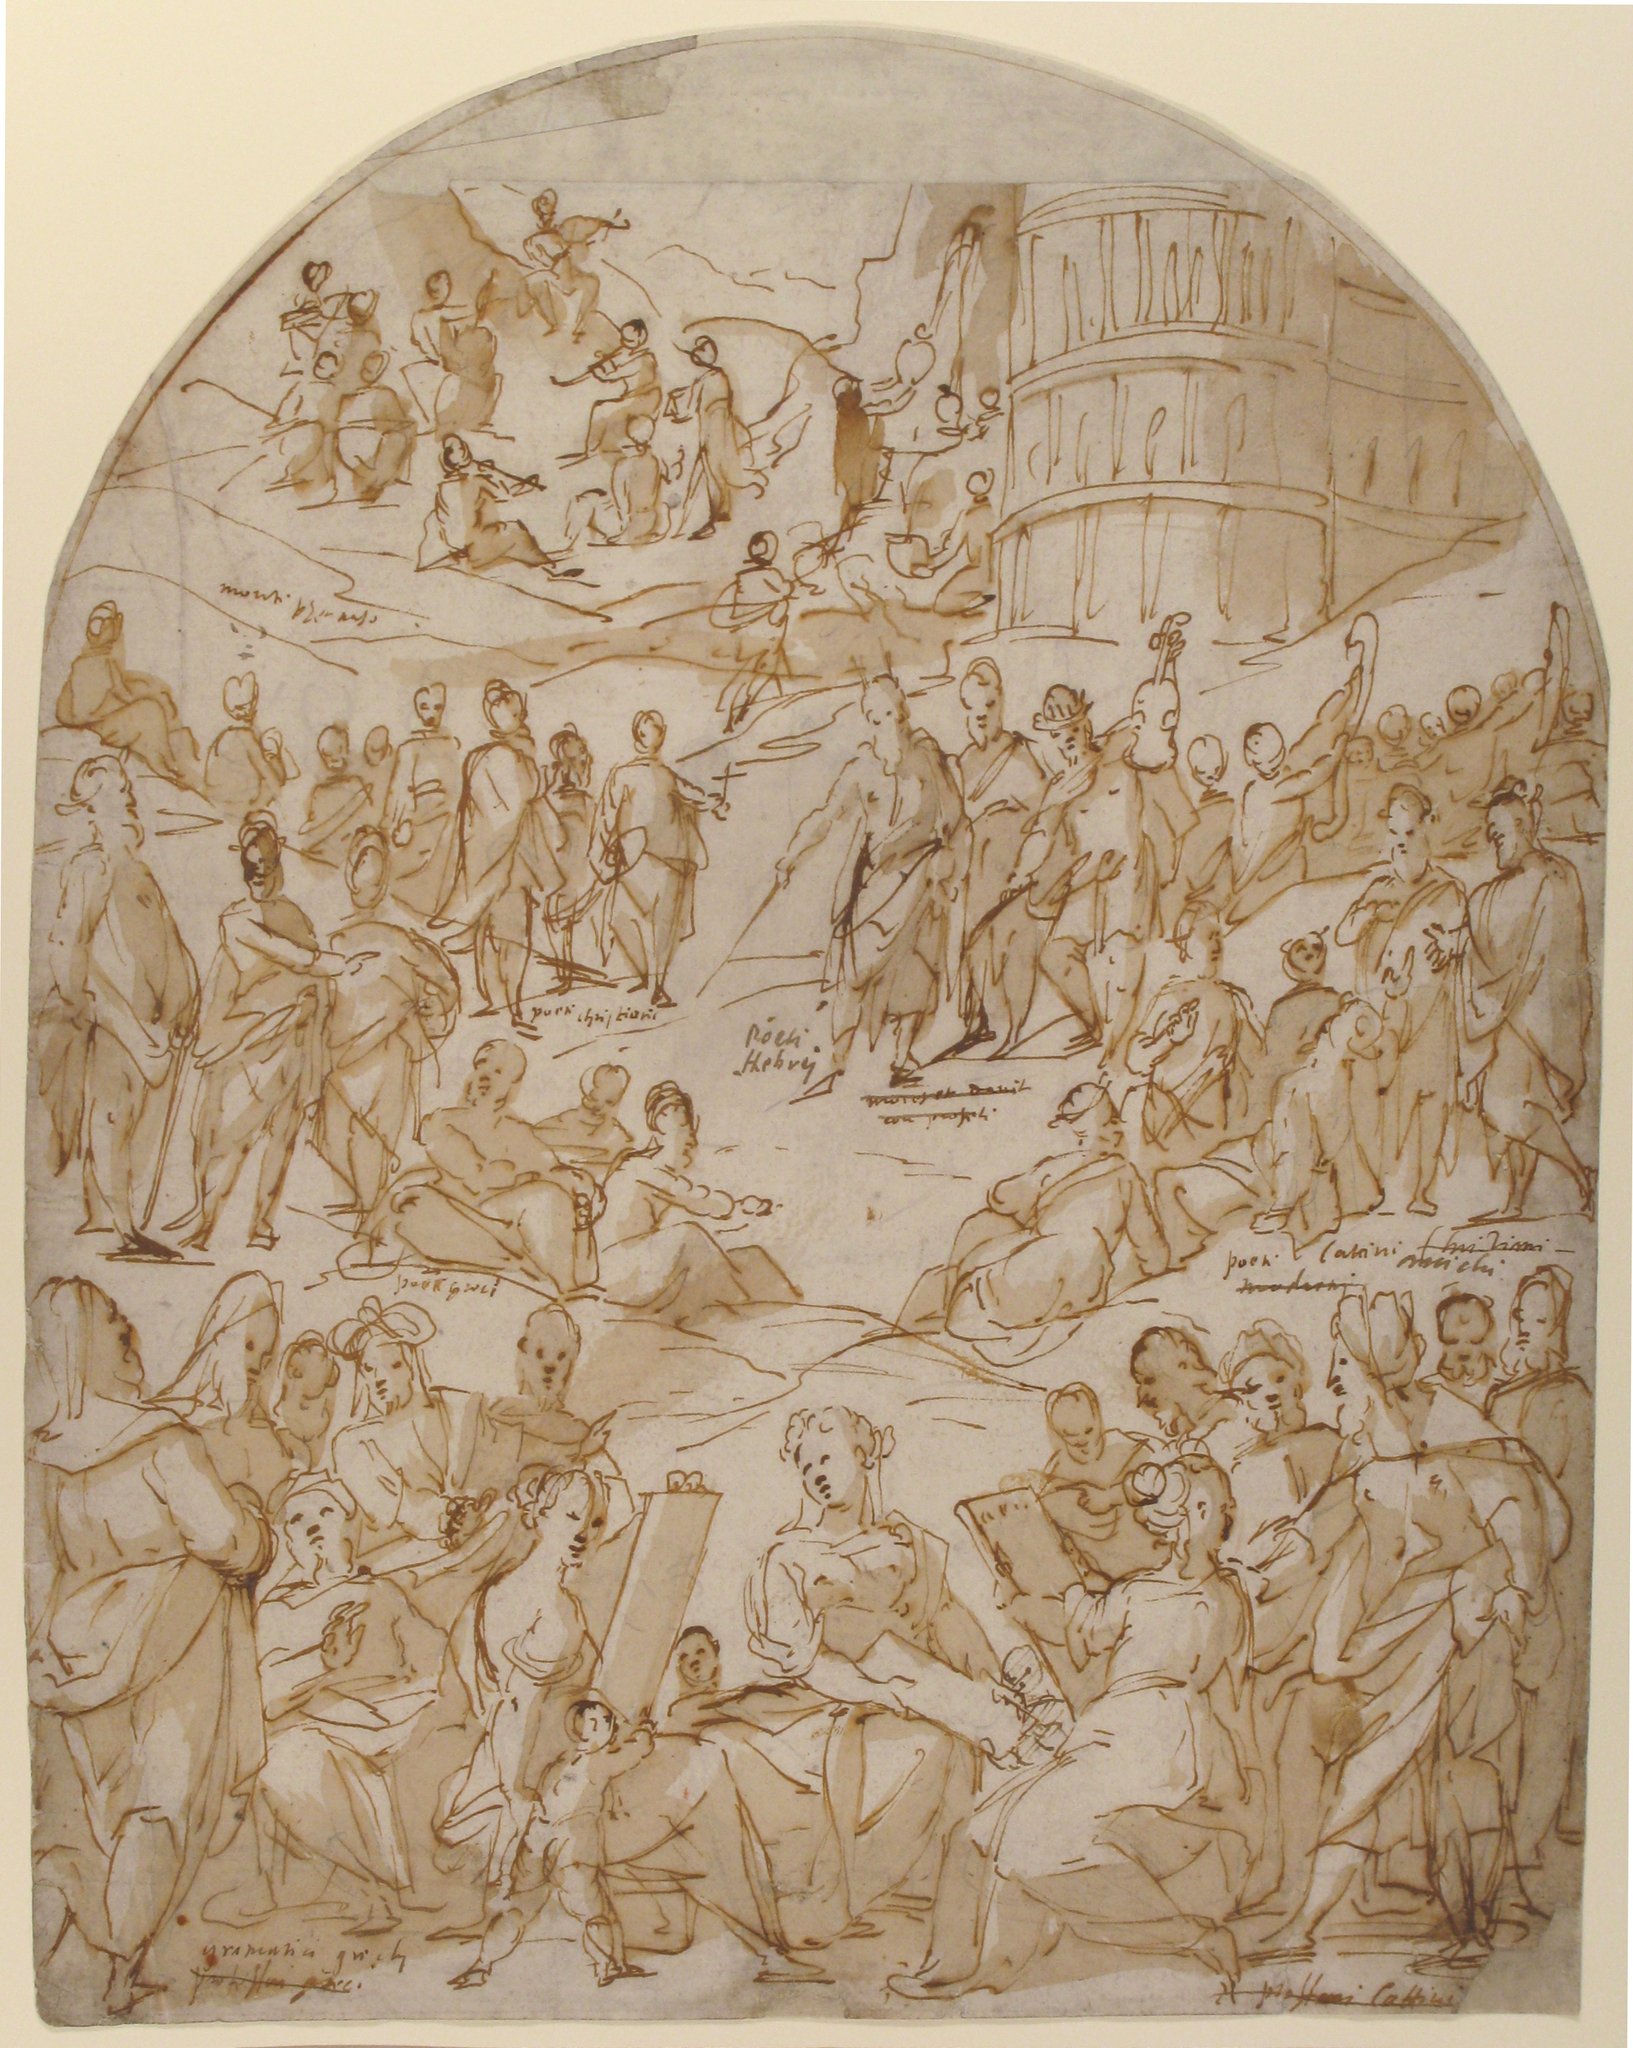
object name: drawing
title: An Allegory of Learning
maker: parrasio micheli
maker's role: artist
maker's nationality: italian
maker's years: 1516-1578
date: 1565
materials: chalk, ink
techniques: brush, pen, wash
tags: buildings,crowd